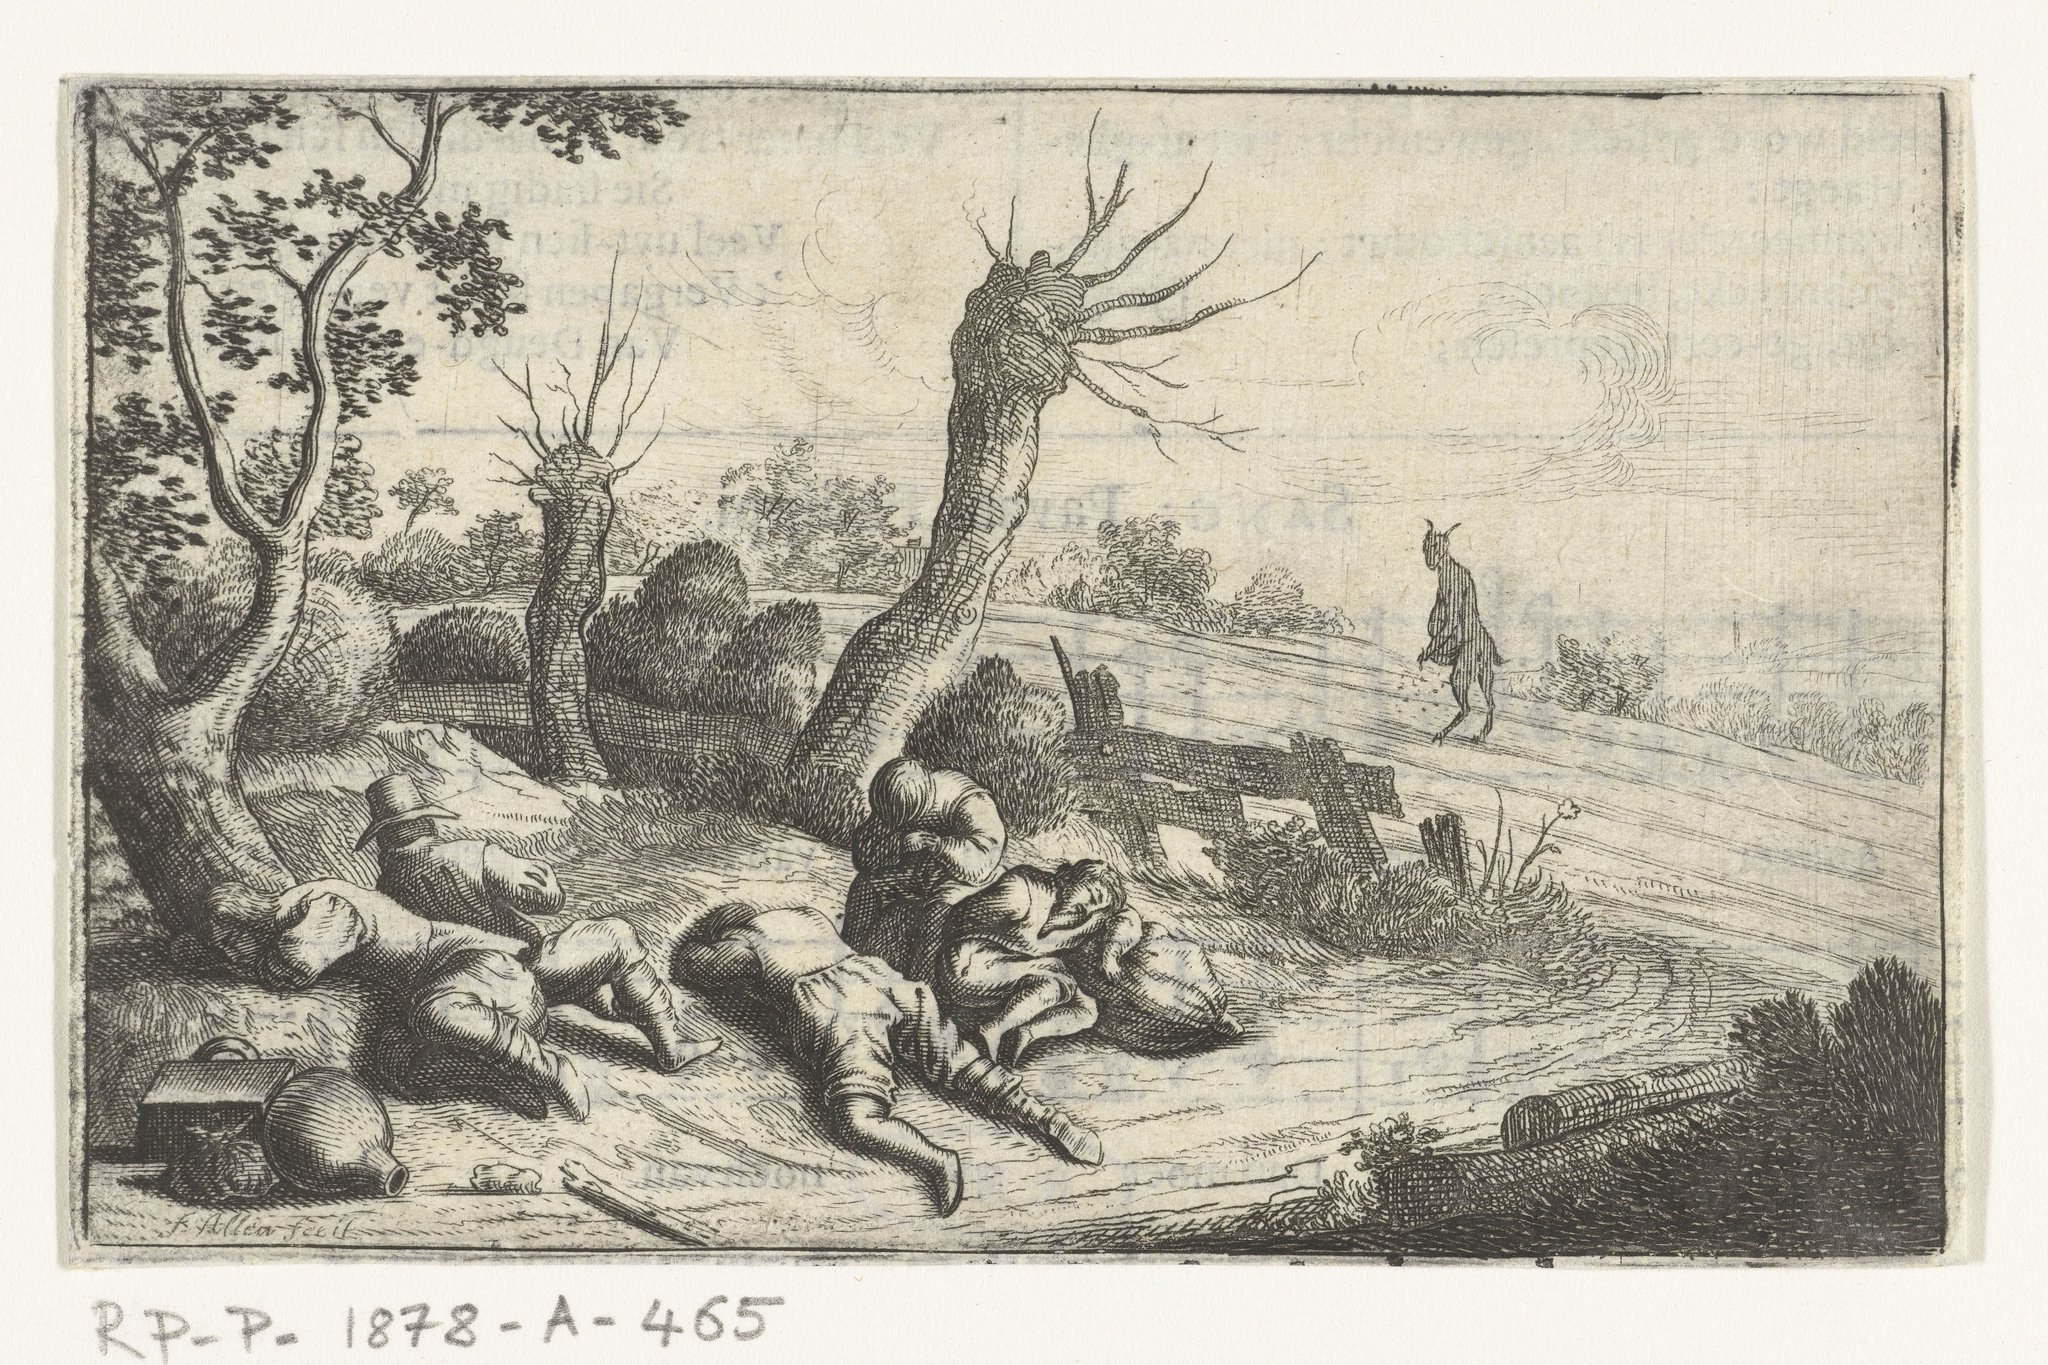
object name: book illustration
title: Satan onkruid zaaiende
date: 1647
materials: paper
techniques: engraving, etching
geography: amsterdam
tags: while the sower and his servants slept, his enemy (the devil) sowed tares among the wheat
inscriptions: collector's mark: Lugt 2228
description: Illustratie uit: D.R. Camphuysen, Stichtelycke rymen, om te lesen ofte singhen, Amsterdam, Iacob Colom, 1647. (in RMA bibliotheek 330 F 3, p. 144). later waarschijnlijk ook gebruikt in: C. Udemans, Af-beeldinge van de verkeerde werelt: ontdeckende de oude aen-geborene verkeertheyt der menschen, Middelburgh, Pieter Goetthem, Henrick Smidt, 1660.